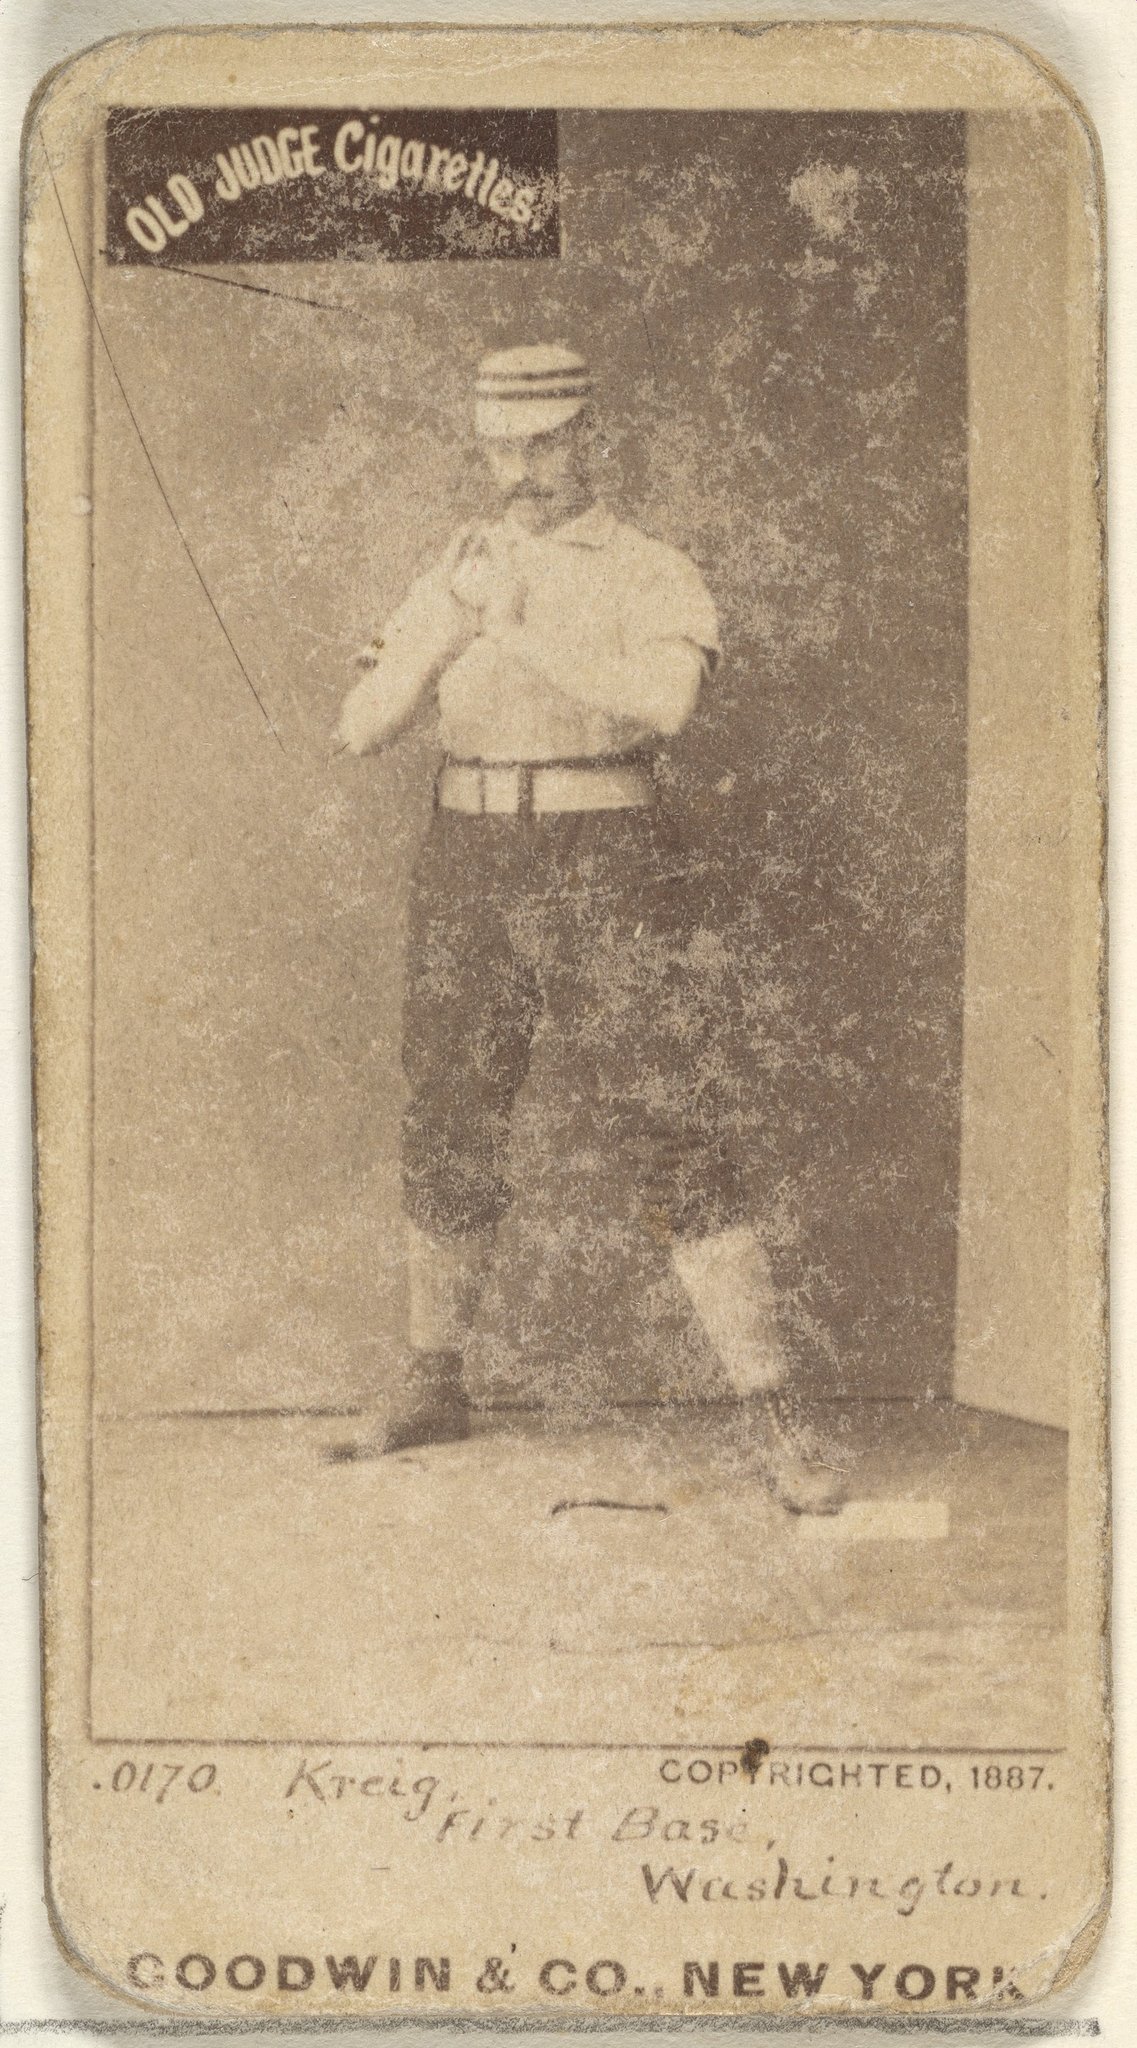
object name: baseball card, photograph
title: William "Bill" Frederick Krieg, 1st Base, Washington Nationals, from the Old Judge series (N172) for Old Judge Cigarettes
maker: goodwin & company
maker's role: publisher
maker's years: 1850-1950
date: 1887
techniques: albumen silver print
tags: men,portraits,baseball,athletes